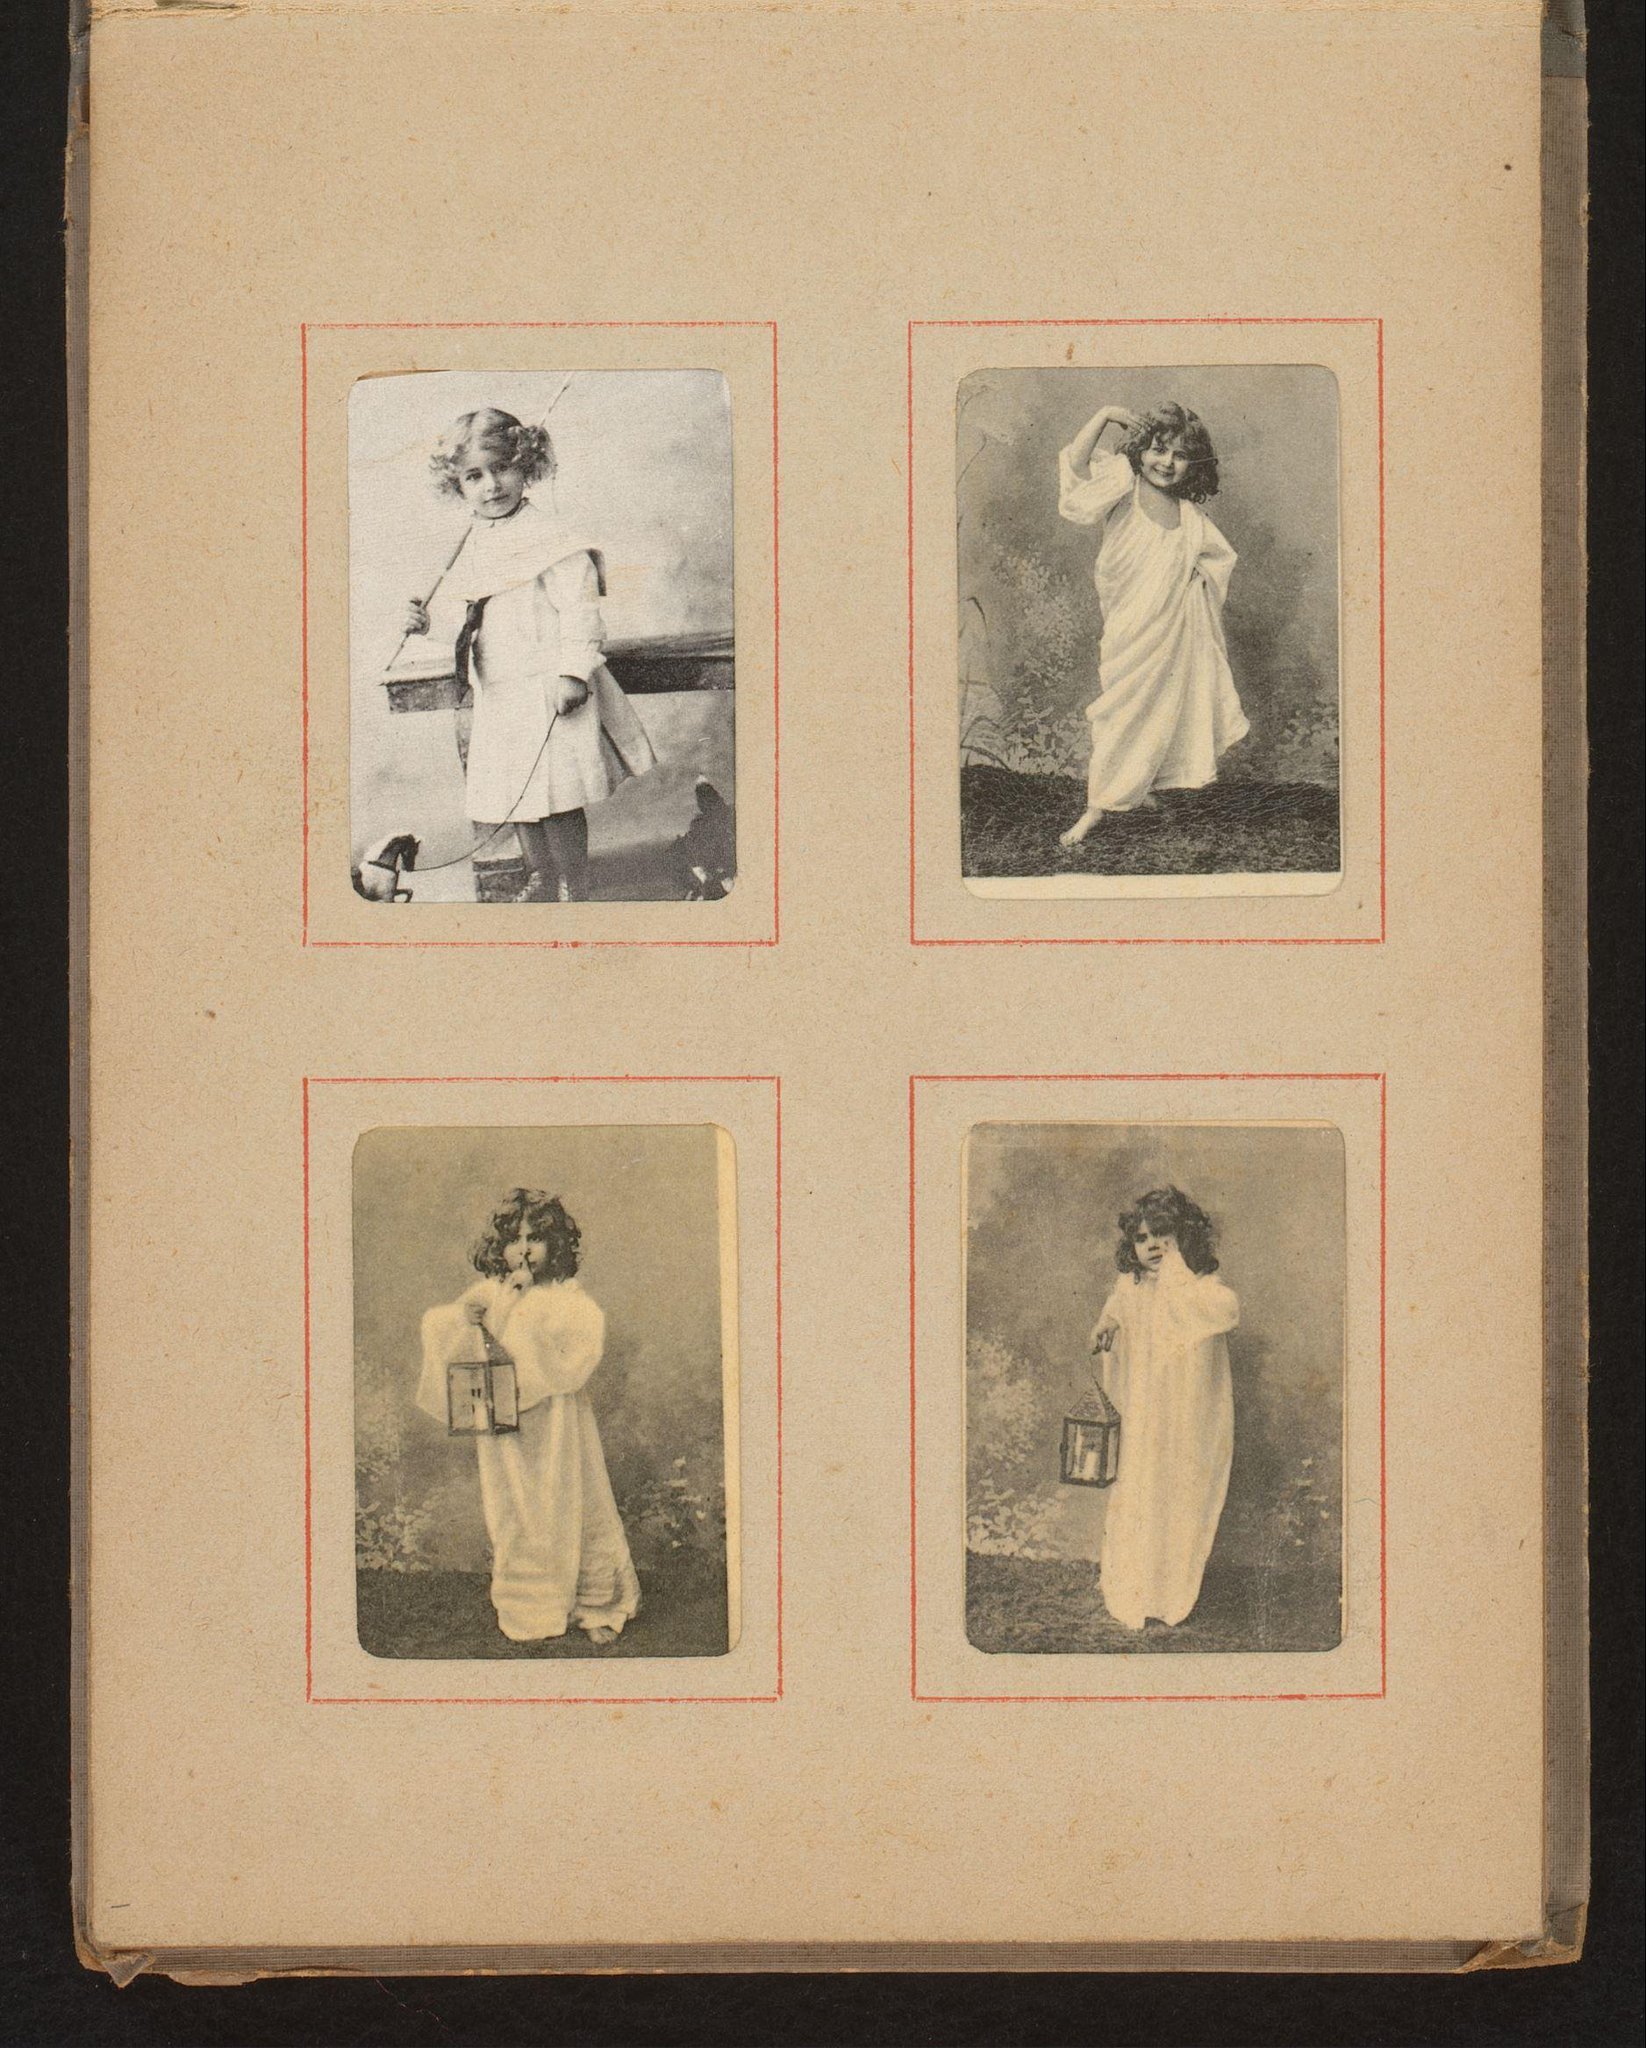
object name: photomechanical print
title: Kinderportretten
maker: Anonymous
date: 1880-1920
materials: paper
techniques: photograph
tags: historical persons, girl (child between toddler and youth), lantern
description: Vier portretten van meisjes, waaronder twee van een meisje met een lantaarn. Deze pagina maakt deel uit van een album.